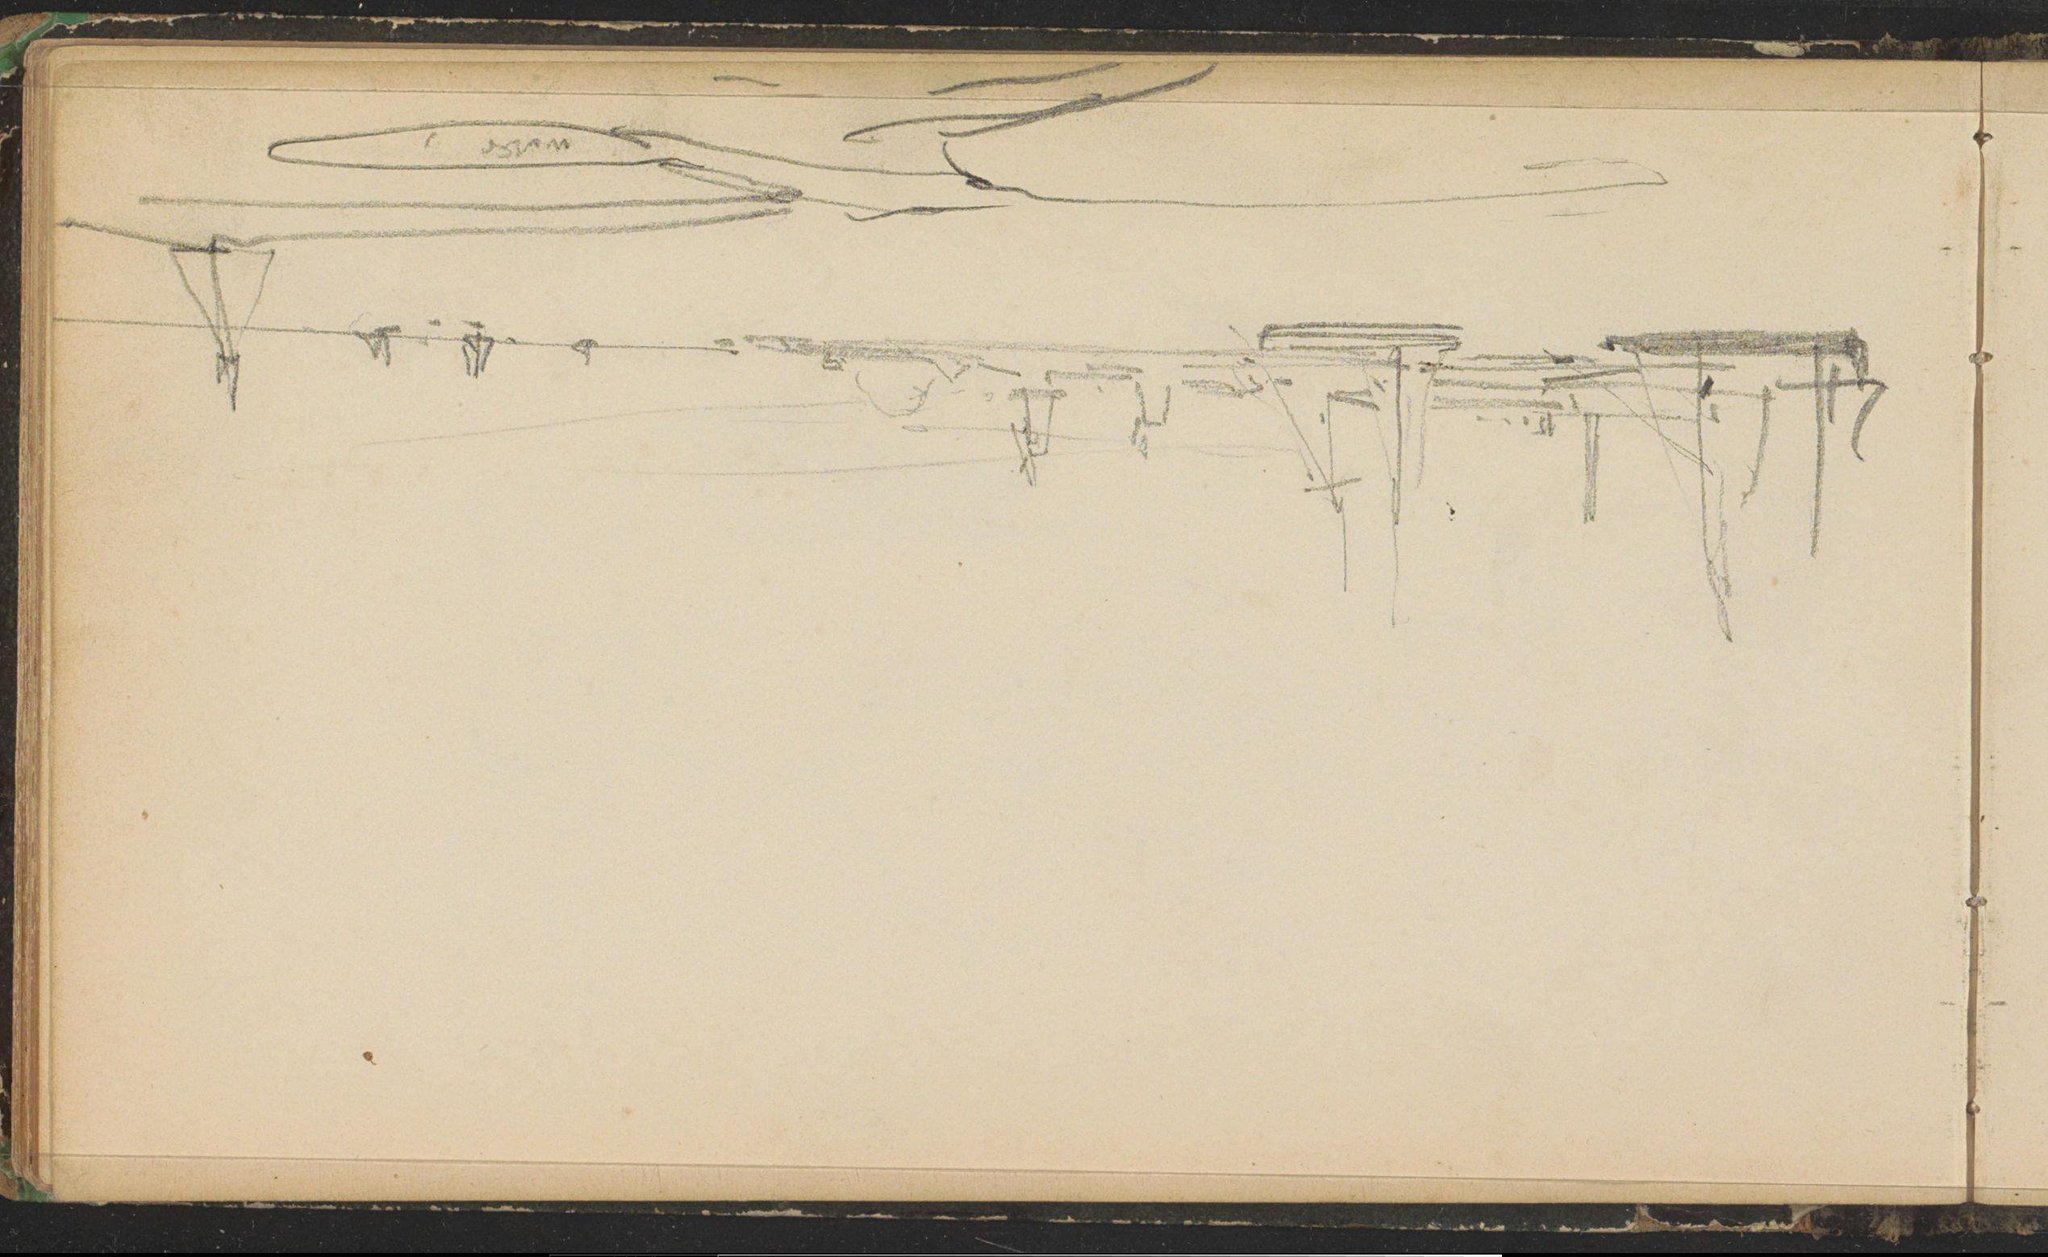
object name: sketchbook leaf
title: Zeilschepen op het water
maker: johannes bosboom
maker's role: draughtsman, painter, print maker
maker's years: 1817-1891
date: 1845-1891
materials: paper, pencil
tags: sailing-ship, sailing-boat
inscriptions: annotation: ‘water’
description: Blad 38 verso uit een schetsboek met 46 bladen.